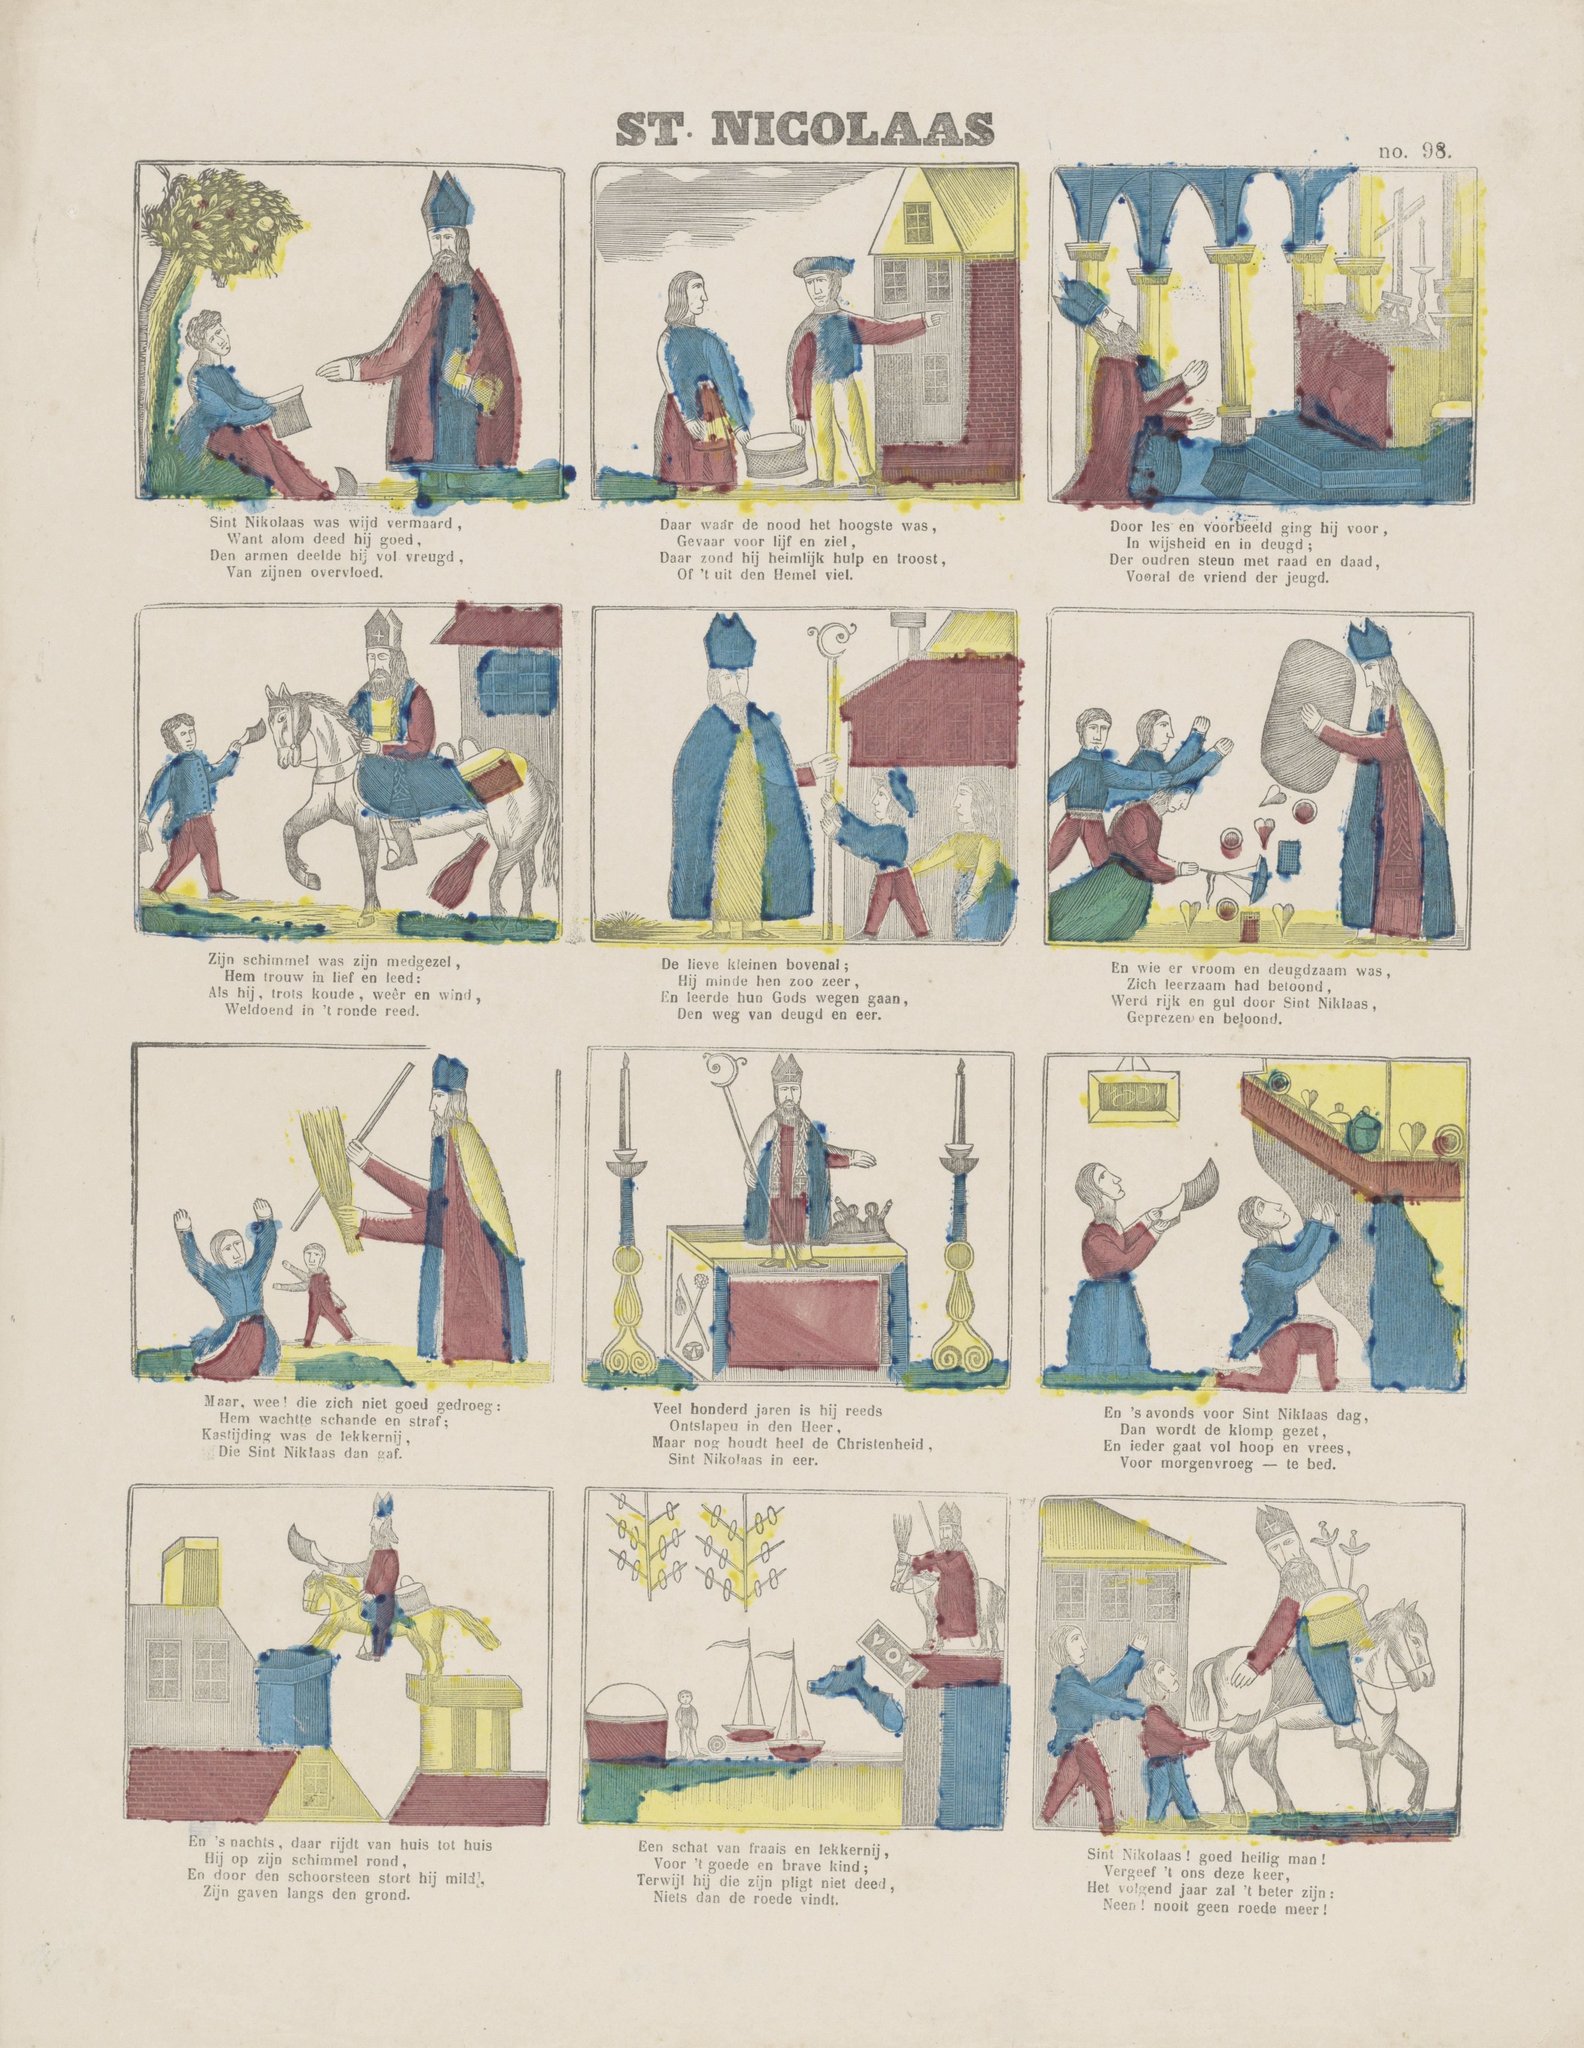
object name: popular print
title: St. Nicolaas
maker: Anonymous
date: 1848-1881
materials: paper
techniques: colour, letterpress printing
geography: den bosch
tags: the bishop nicholas of myra (or bari); possible attributes: anchor, boat, three golden balls (on a book), three purses, three children in a tub, three maidens, festivities on st. nicholas (eve) (december 5)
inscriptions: collector's mark: Lugt 2760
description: Blad met 12 voorstellingen over Sint Nicolaas en het Sinterklaasfeest. Onder elke afbeelding een vierregelig vers. Rechtsboven genummerd: no. 98.